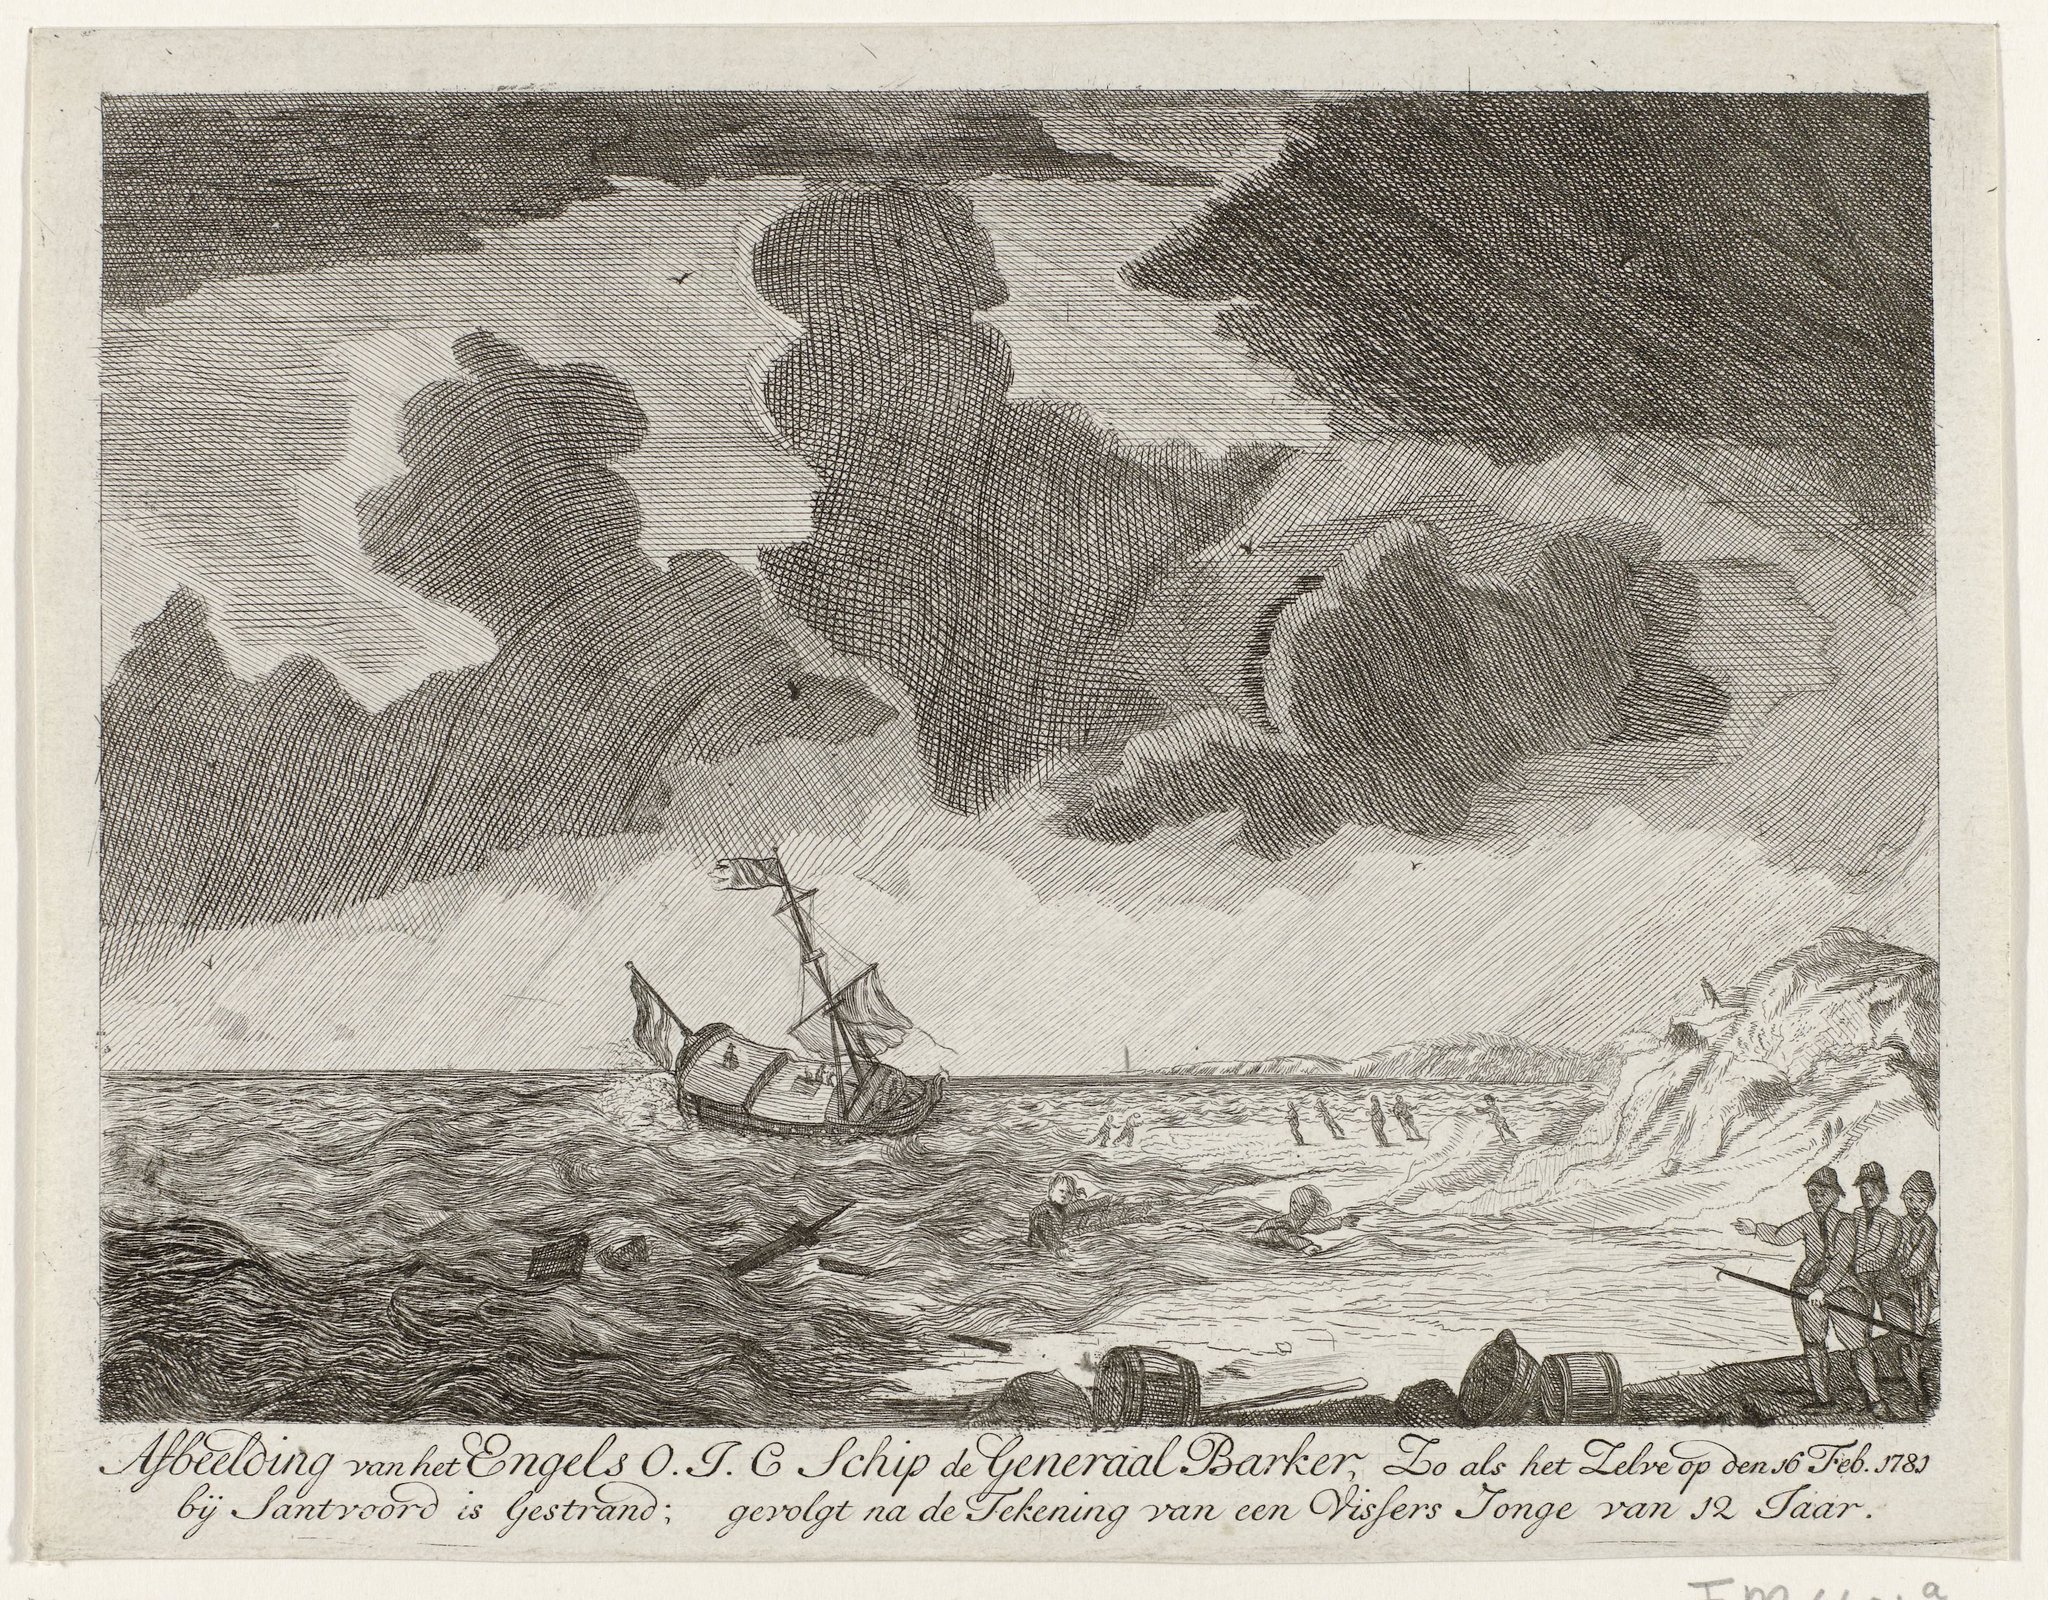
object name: print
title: Afbeelding van het Engels O.I.C. Schip de Generaal Barker, Zo als het Zelve op den 16 Feb. 1781 bij Santvoord is Gestrand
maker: Anonymous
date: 1781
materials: paper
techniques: engraving, etching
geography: northern netherlands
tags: wreck ashore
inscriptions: collector's mark: Lugt 2228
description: Stranding van de Engelse Oost-Indiëvaarder Generaal Barker bij Zandvoort, 16 februari 1781. Zeelieden en delen van de lading spoelen aan bij de kust.